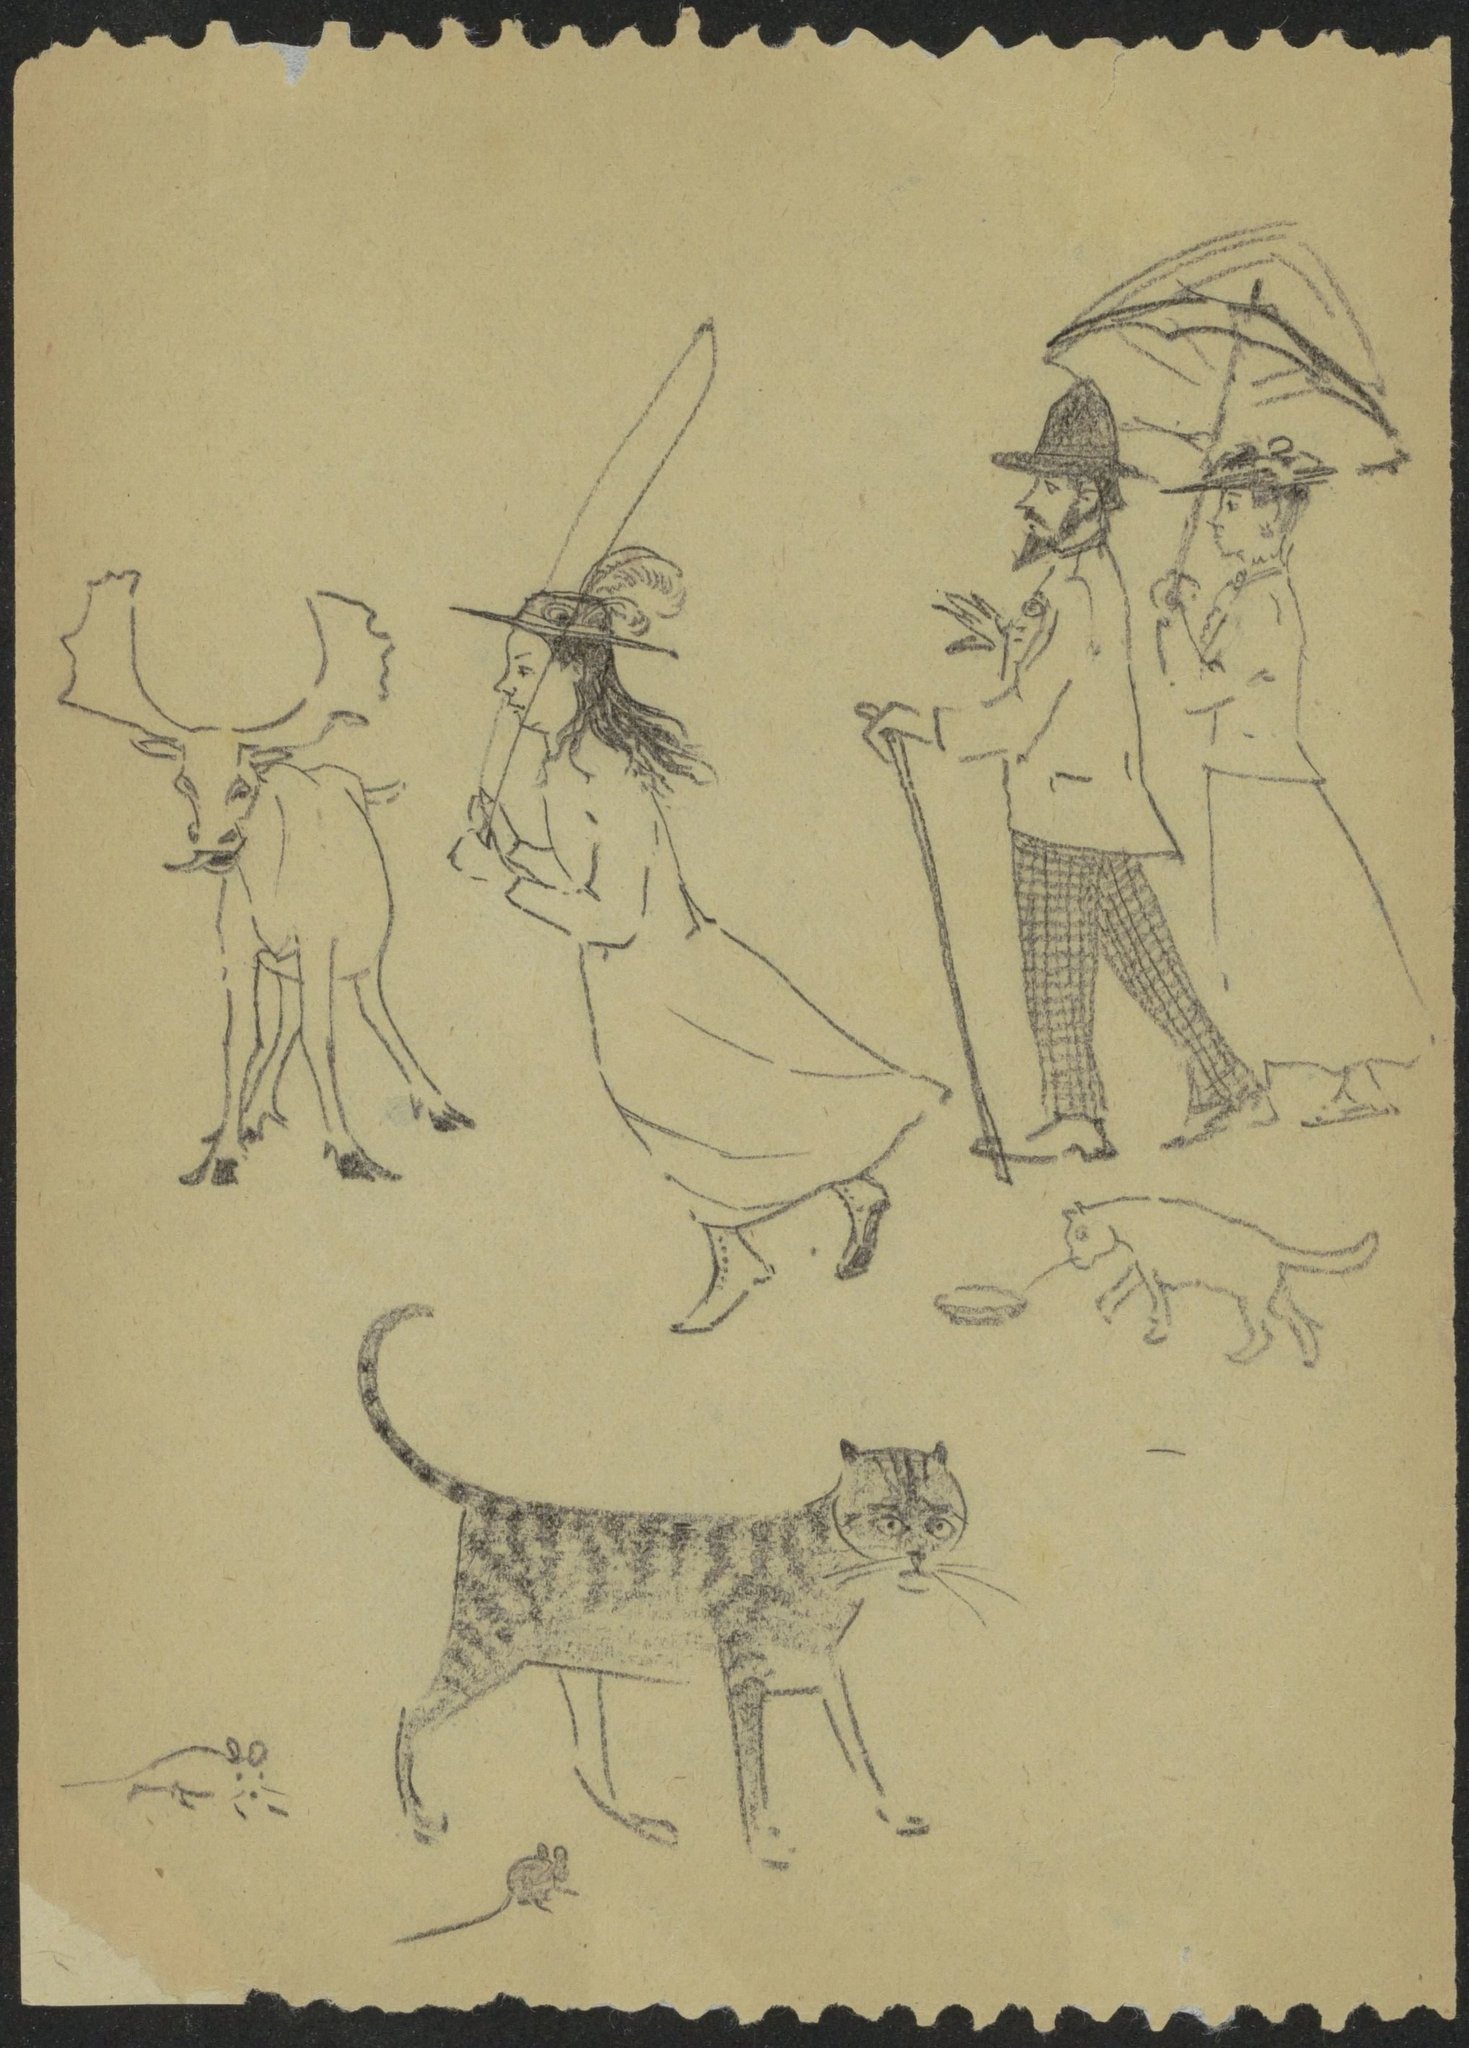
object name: drawing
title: Studieblad, onder andere met een wandelend paar, katten en muizen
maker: gerrit willem dijsselhof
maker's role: designer, draughtsman, print maker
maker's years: 1866-1924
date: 1904-1906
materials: chalk, paper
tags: rodents: mouse, cat, walking, hoofed animals: elk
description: Tevens studies van een wandelend meisje en een eland.